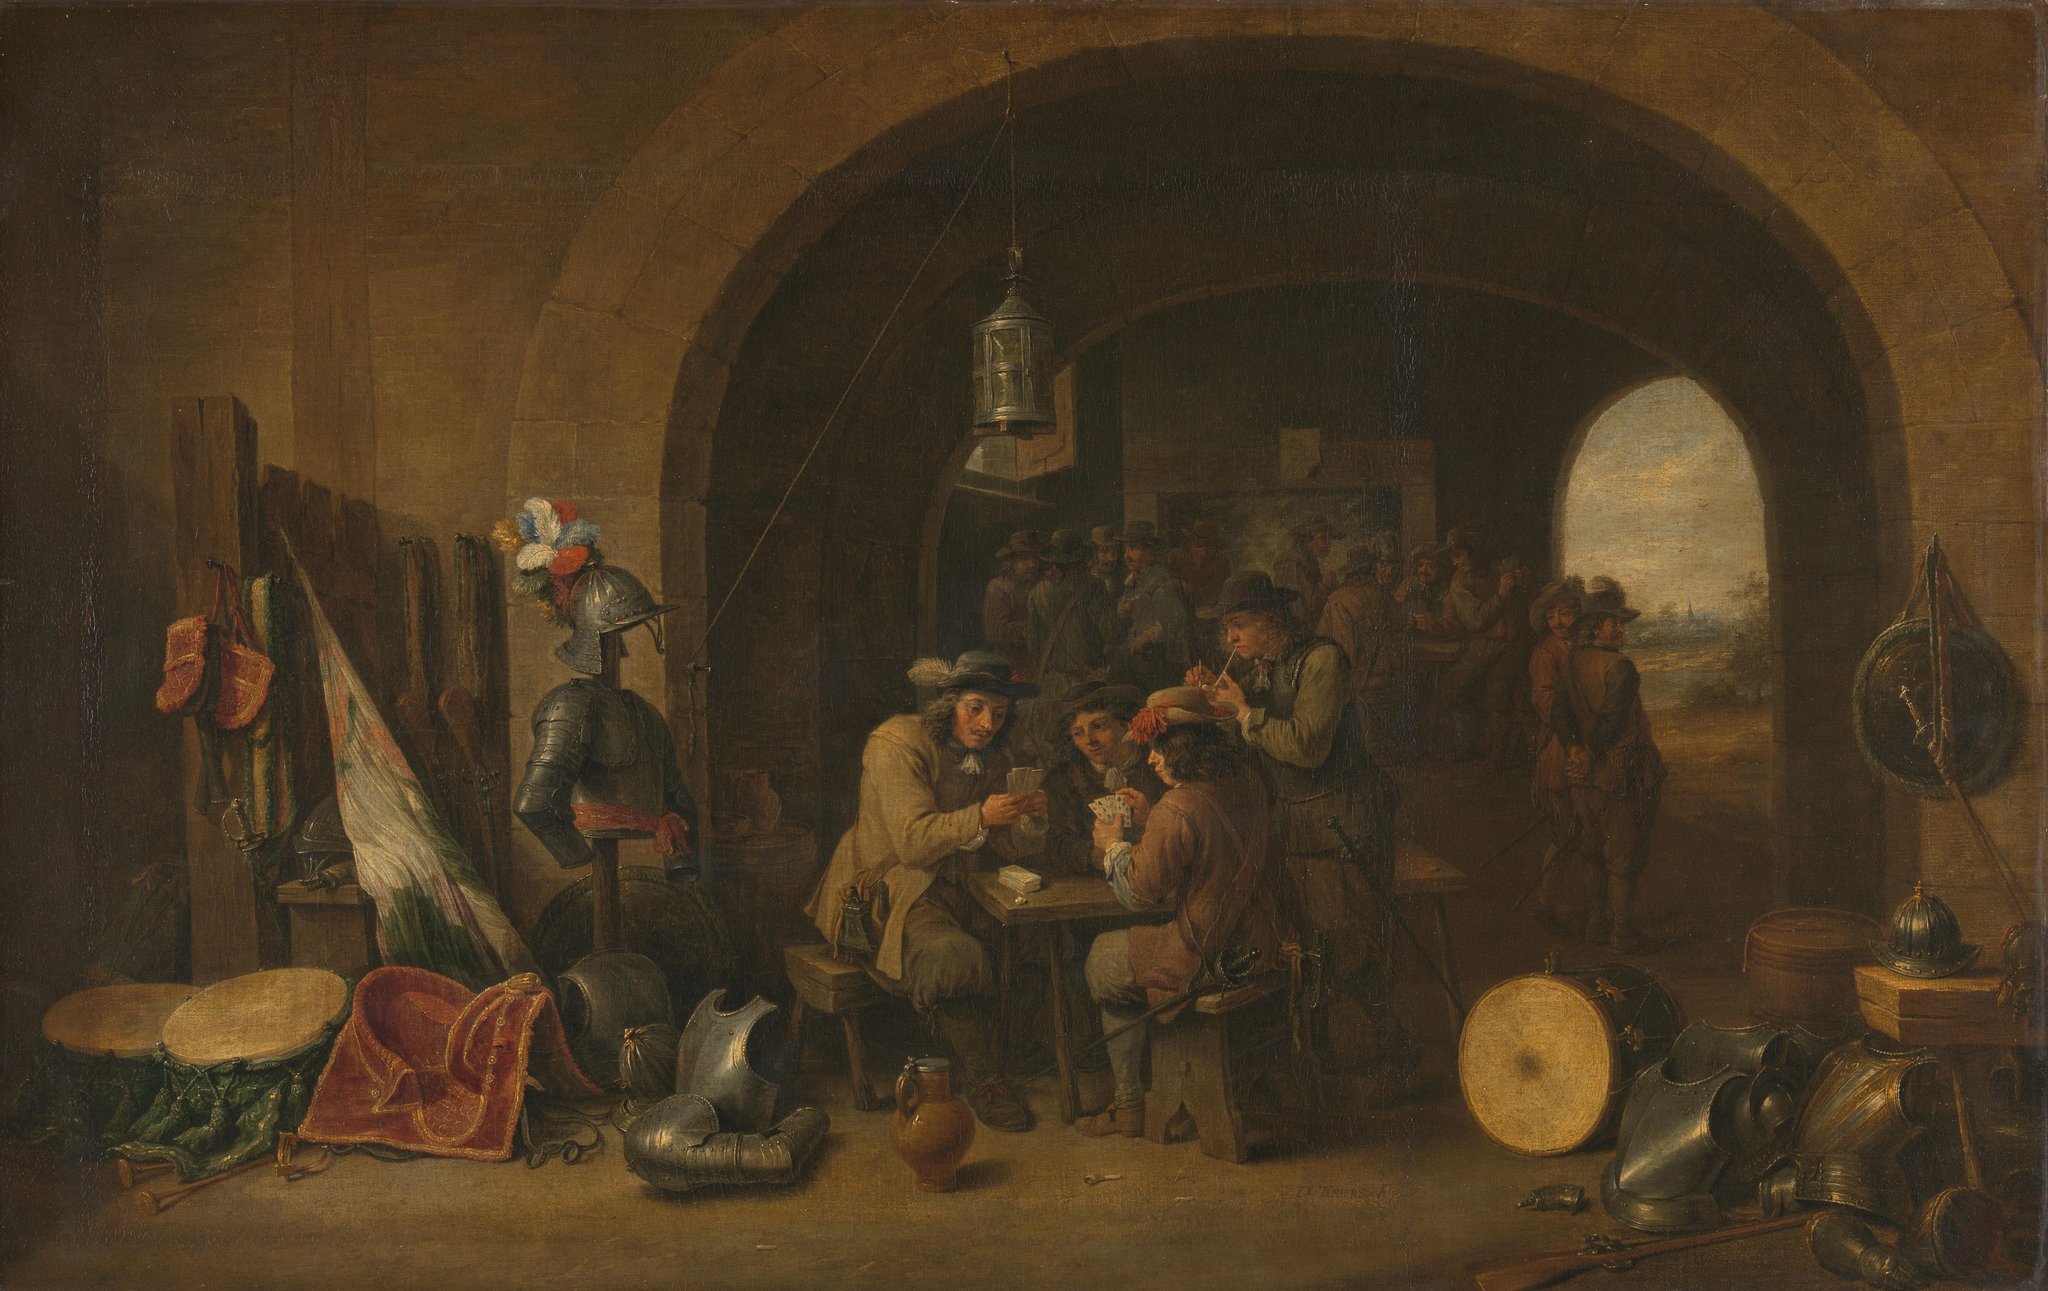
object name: painting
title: Guardroom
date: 1670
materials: canvas, oil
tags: in the guard-room, 'kortegaard'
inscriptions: inscription, lower right of centre, with signature and indistinct date: ‘D:TENIERS∙F∙ 164[1]’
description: Soldatenwacht. Wachtkamer met een groepje kaartende soldaten. Op de voorgrond liggen delen van wapenrustingen, wapens, vaandels en trommels. Boven de tafel hangt een lantaarn aan een touw. Op de achtergrond meer staande en zittende soldaten.